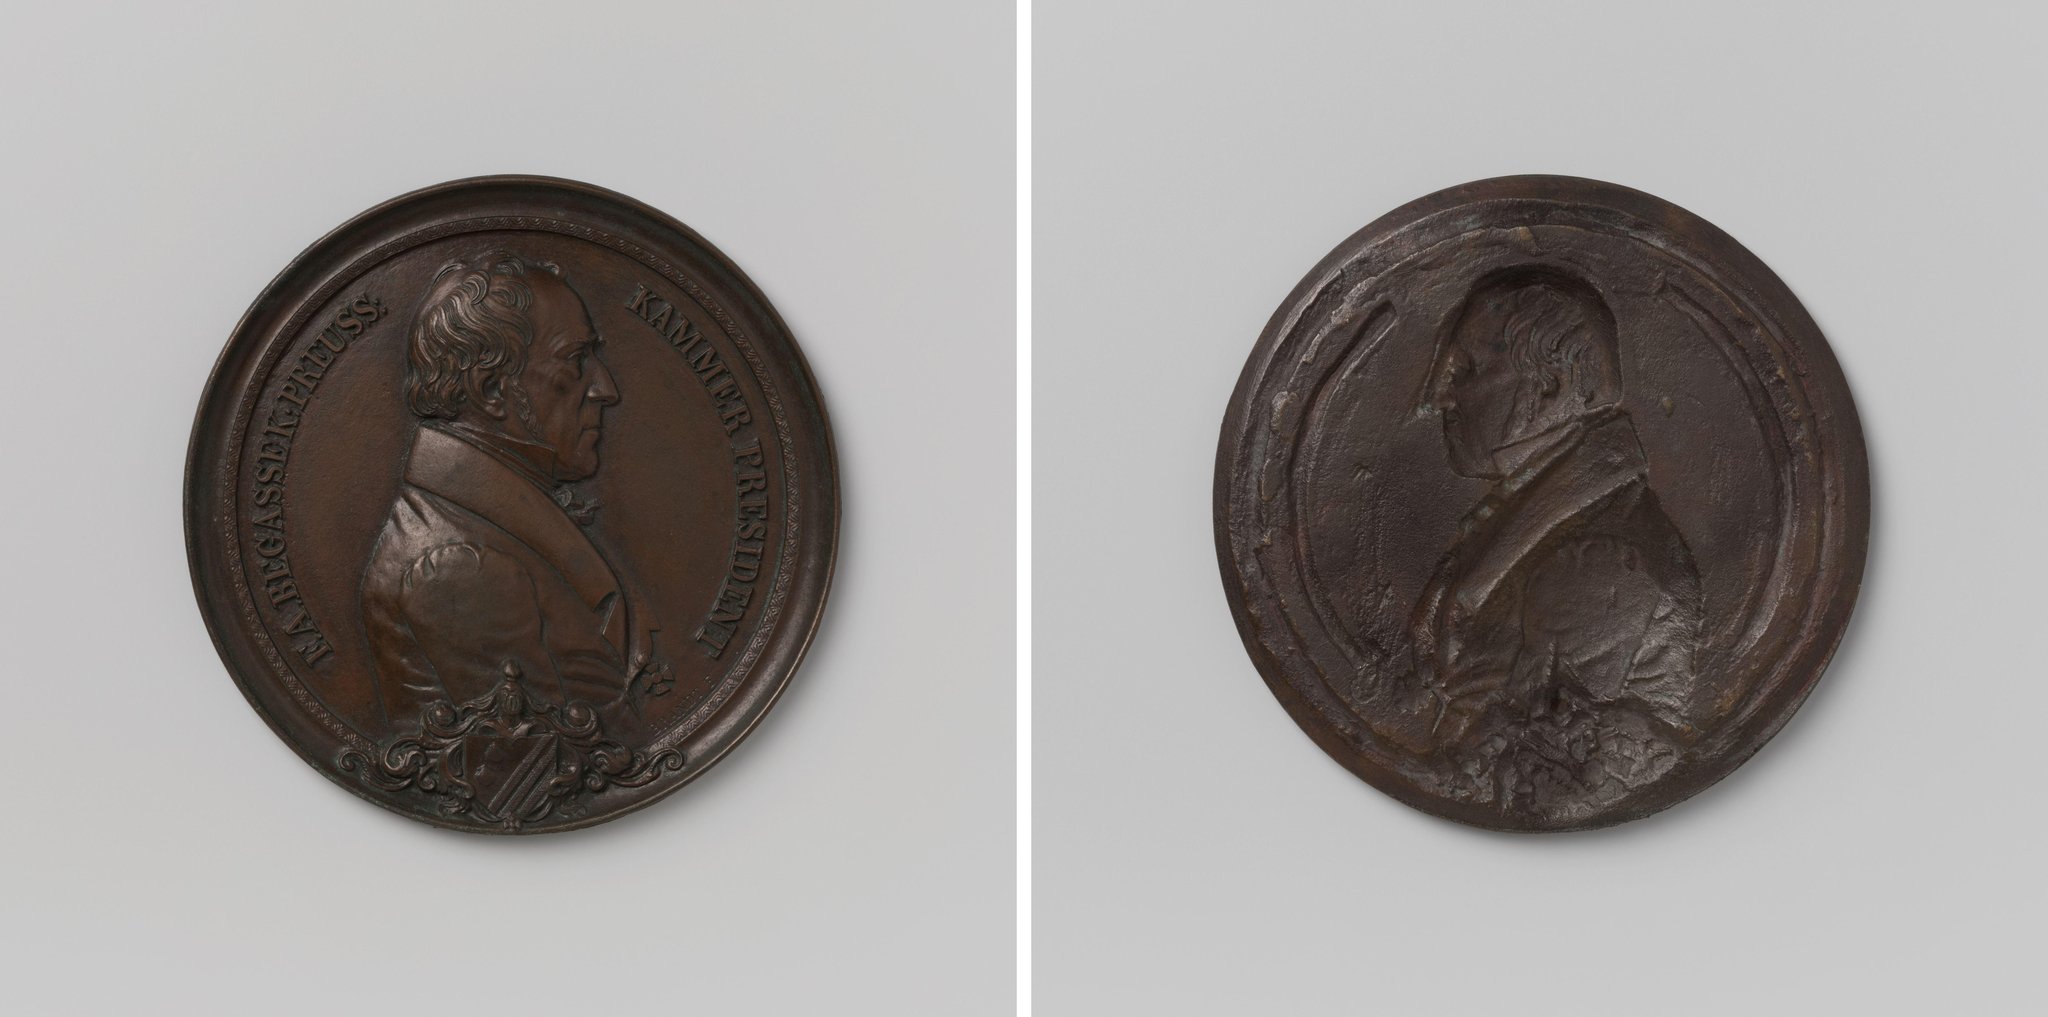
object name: plaque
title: F.A. Begasse, 'Kammerpresident' van de koning van Pruisen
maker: henri-françois brandt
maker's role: painter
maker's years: 1789-1845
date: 1817-1845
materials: bronze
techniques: casting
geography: berlin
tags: berlin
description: eenzijdige plaquette. Voorzijde: borststuk man naar rechts boven wapenschild in cartouche binnen omschrift. Keerzijde: blanco